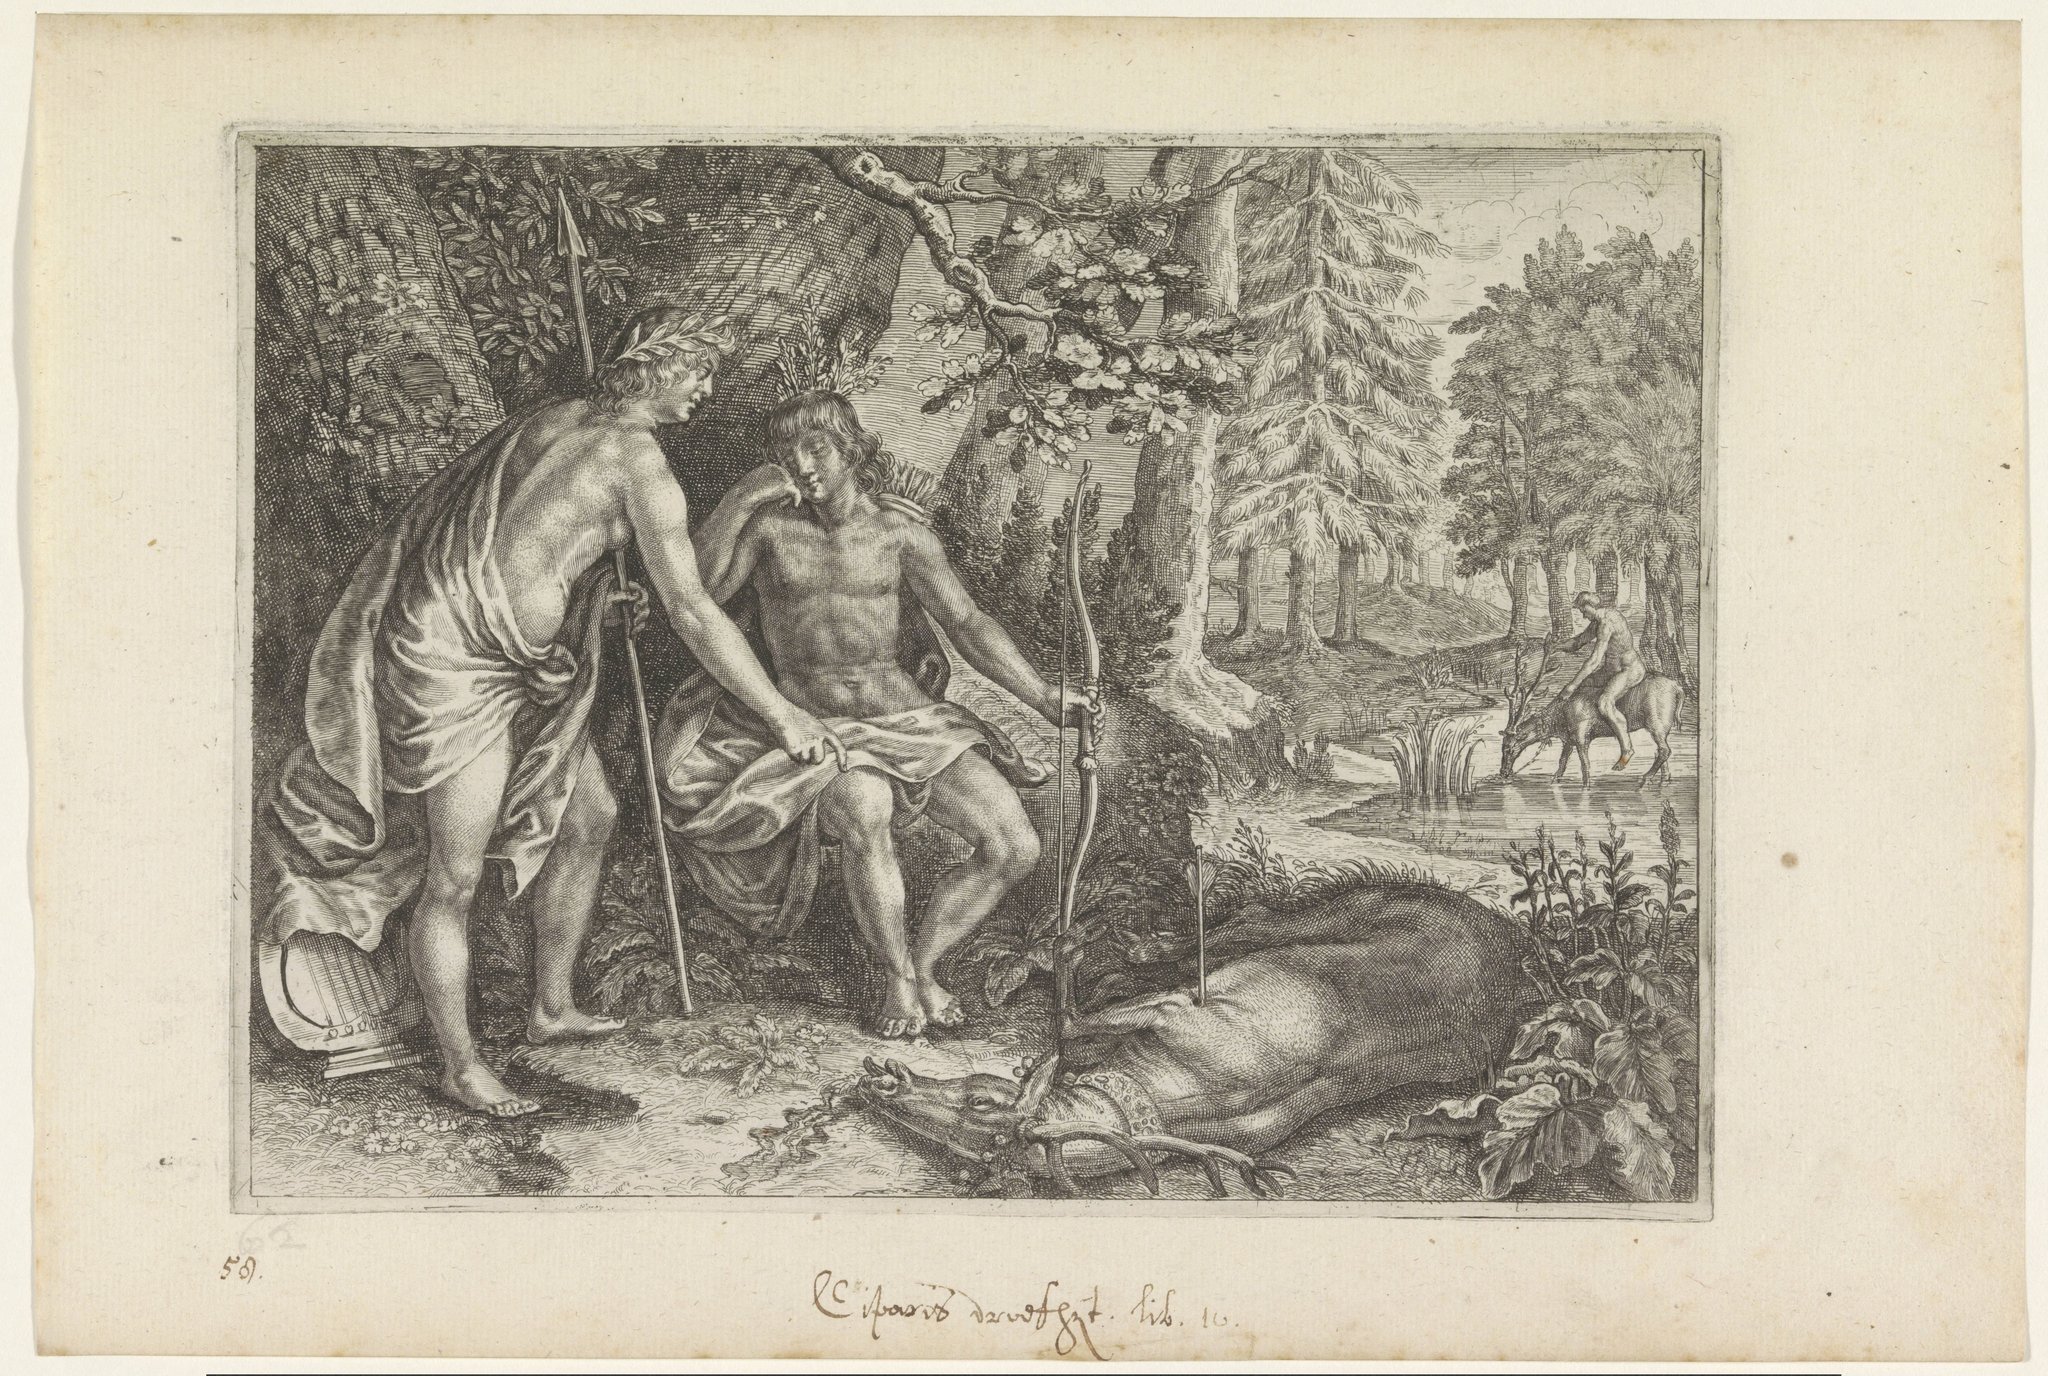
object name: print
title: Metamorfosen van Ovidius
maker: crispijn van de passe (ii)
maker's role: draughtsman, print maker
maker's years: 1594-1670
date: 1636-1670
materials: paper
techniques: engraving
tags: homosexual love, apollo and cyparissus, usually with his stag, cyparissus changed into a cypress: when pining away for the loss of his favourite stag, cyparissus the hunter, minion of apollo, is changed into a cypress by the god (ovid, metamorphoses x 106)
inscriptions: annotation: ‘Ciparis droefhijt. lib. 10.’, collector's mark: ‘Hinloopen’, number: ‘58’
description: Deze incomplete serie, bestaande uit 77 van de in totaal 85 prenten met scènes uit Ovidius' Metamorfosen, werd in 1709 samen met Ovidius-illustraties van Tempesta, Goltzius en Le Pautre in één album, Schijnvoet nummer 43, ingebonden. In de negentiende eeuw werd deze band weer uit elkaar gehaald.